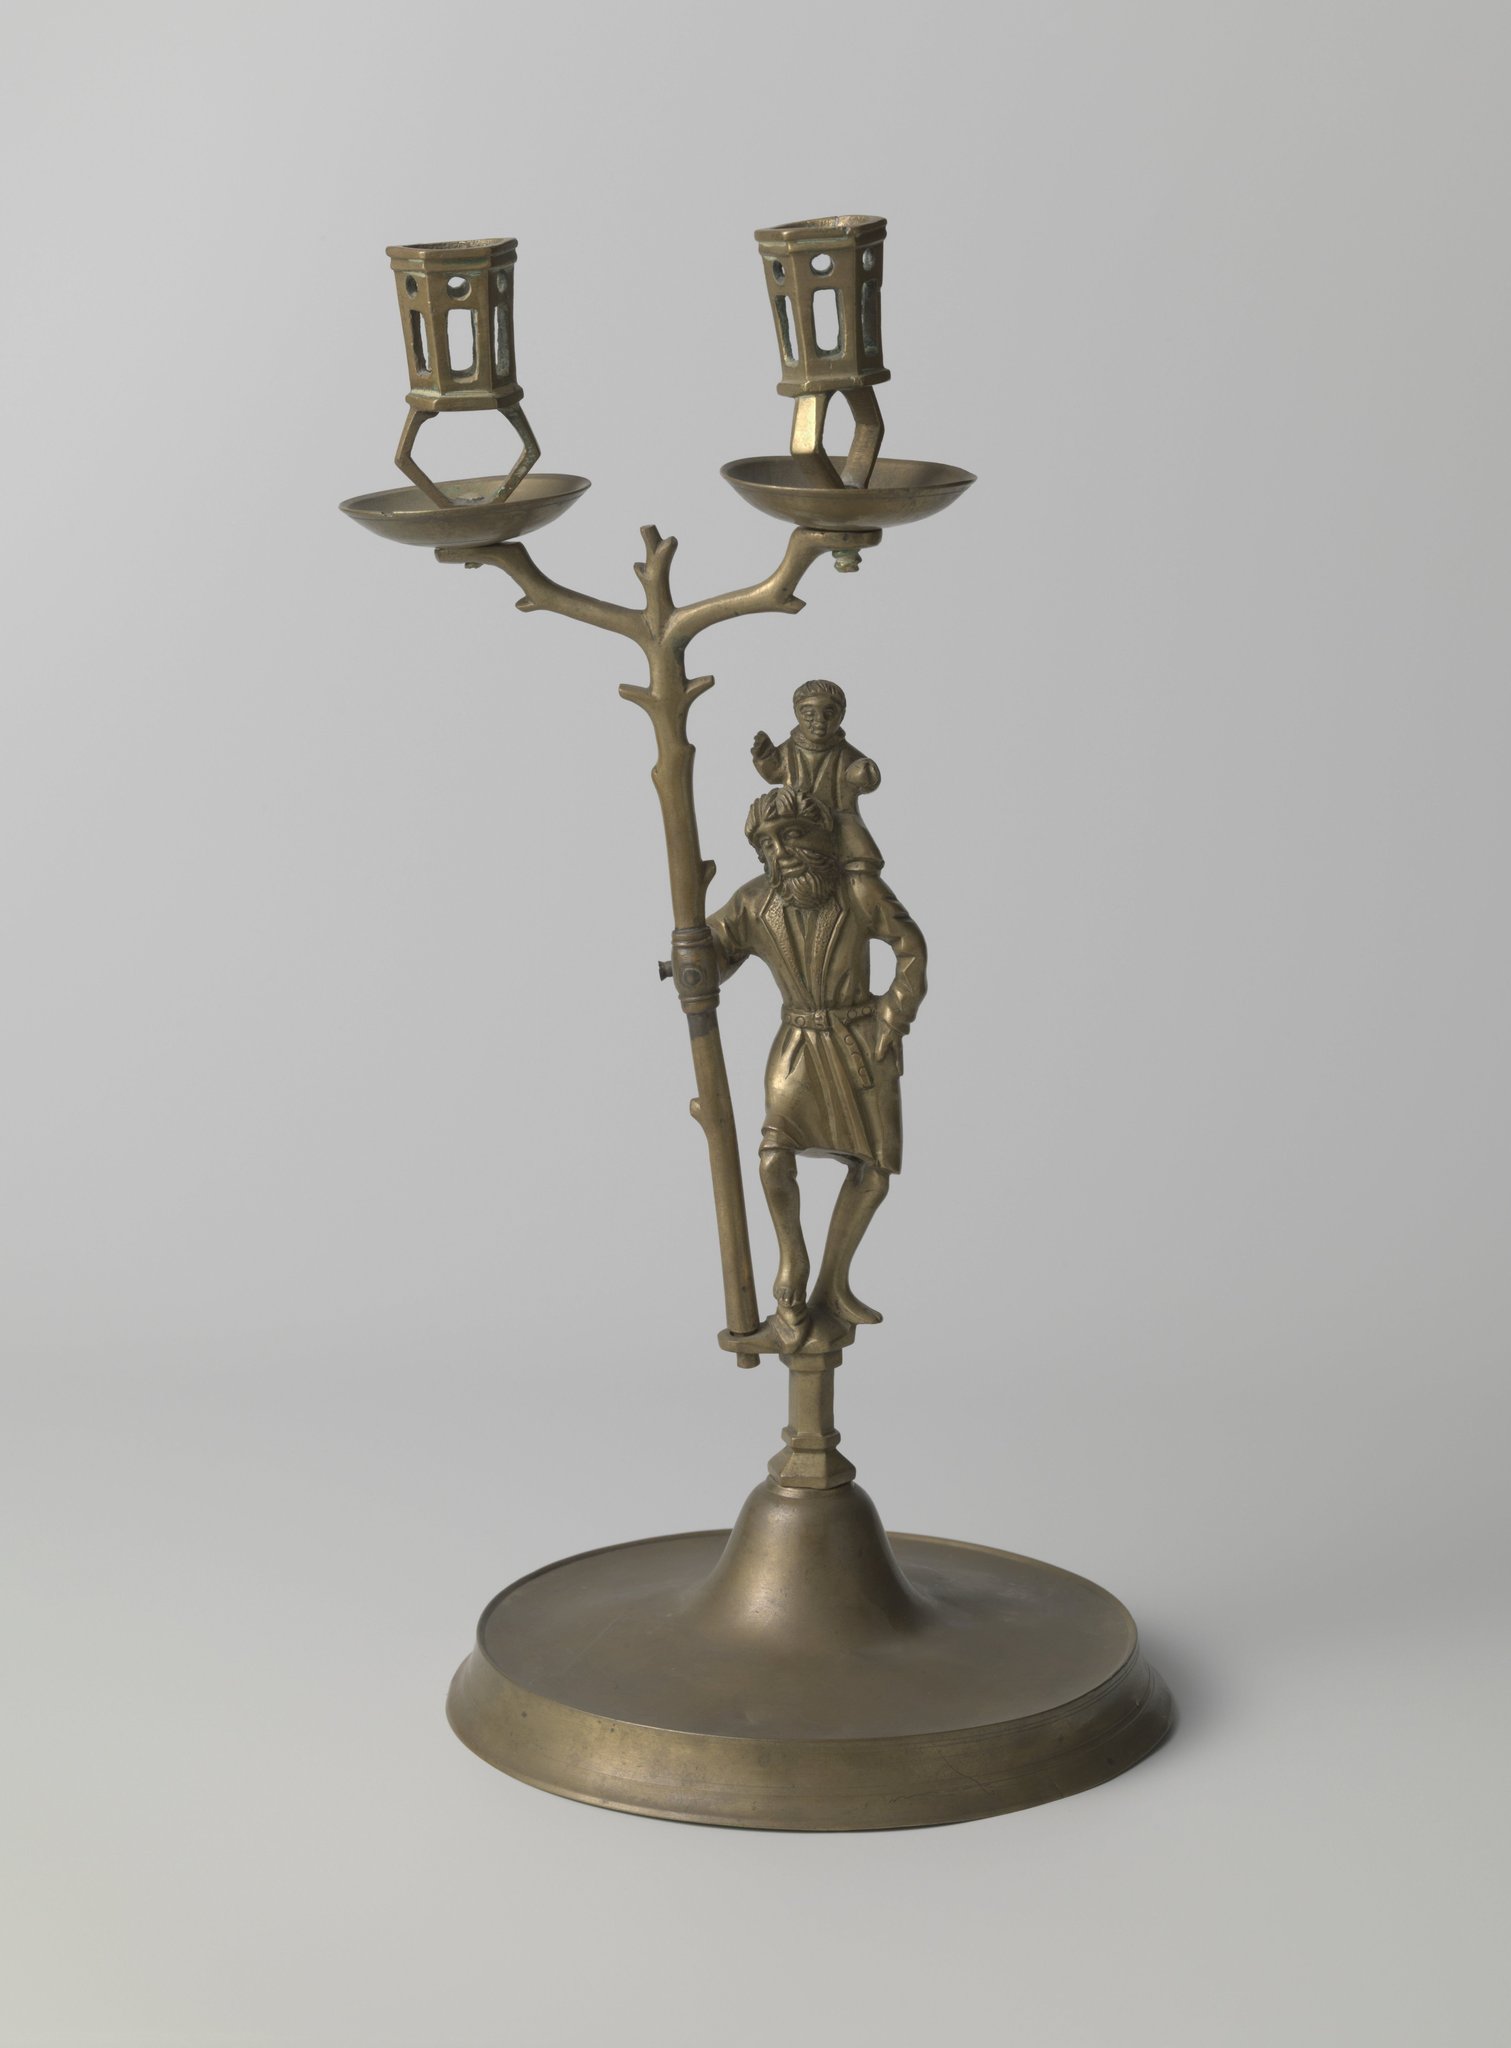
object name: candlestick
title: Twee-armige kandelaar met de heilige Christophorus en het Christuskind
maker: Anonymous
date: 1825-1875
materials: brass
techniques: casting, granulation, screwed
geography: germany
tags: the giant and martyr christophorus; possible attributes: palm-tree (with bunches of dates, or withered), infant christ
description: De kandelaar is samengesteld uit de volgende delen: de voet, de stam met de H. Christophorus, de twee vetvangers en de twee kaarsenhouders. De lage ronde, met gegroefde ringen versierde voet, loopt uit in een standring. Deze heeft bovenaan een opstaand randje, waardoor het horizontale vlak van de voet als vetvanger dienst kan doen. De voet verhoogt zich naar het midden toe en heeft aldaar een door een ronde rand omgeven gat, waarin de stam is geschoefd. Deze is onderaan zeshoekig en voorzien van een basis en een kapiteel. Hierop staat de barrevoets gaande H. Christophorus, die het Christuskind op de schouders draagt. Het voetstuk waarop de H. Christophorus is geplaatst heeft een uitsteeksel, waarin de boom is gestoken, die aan de rechter arm van de heilige is geschroefd. De boom heeft twee takken, waarin aan de uiteinden de kaarsenhouders op de vetvangers zijn geschroefd. De heilige draagt een tot aan de knieën reikende mantel, waarvan de boorden zijn gegranuleerd, en een riem, die met rondjes is verlevendigd. Het Christuskind draagt een mantel waarvan de zoom en de kraag gegranuleerd zijn. De ronde vetvangers zijn aan de onderzijde (verschillend) van ringen voorzien. De geprofileerde kaarsenhouders zijn zesvlakkig en telkens voorzien van een staande rechthoekige en een ronde opening. Deze zijn geplaatst op verticale zeshoekige verbindingsstukken. De boomstam is ter hoogte van de rechter hand van Christoffel gebroken geweest, aldaar gedeeltelijk vernieuwd en met een ijzeren schroef in de arm bevestigd.